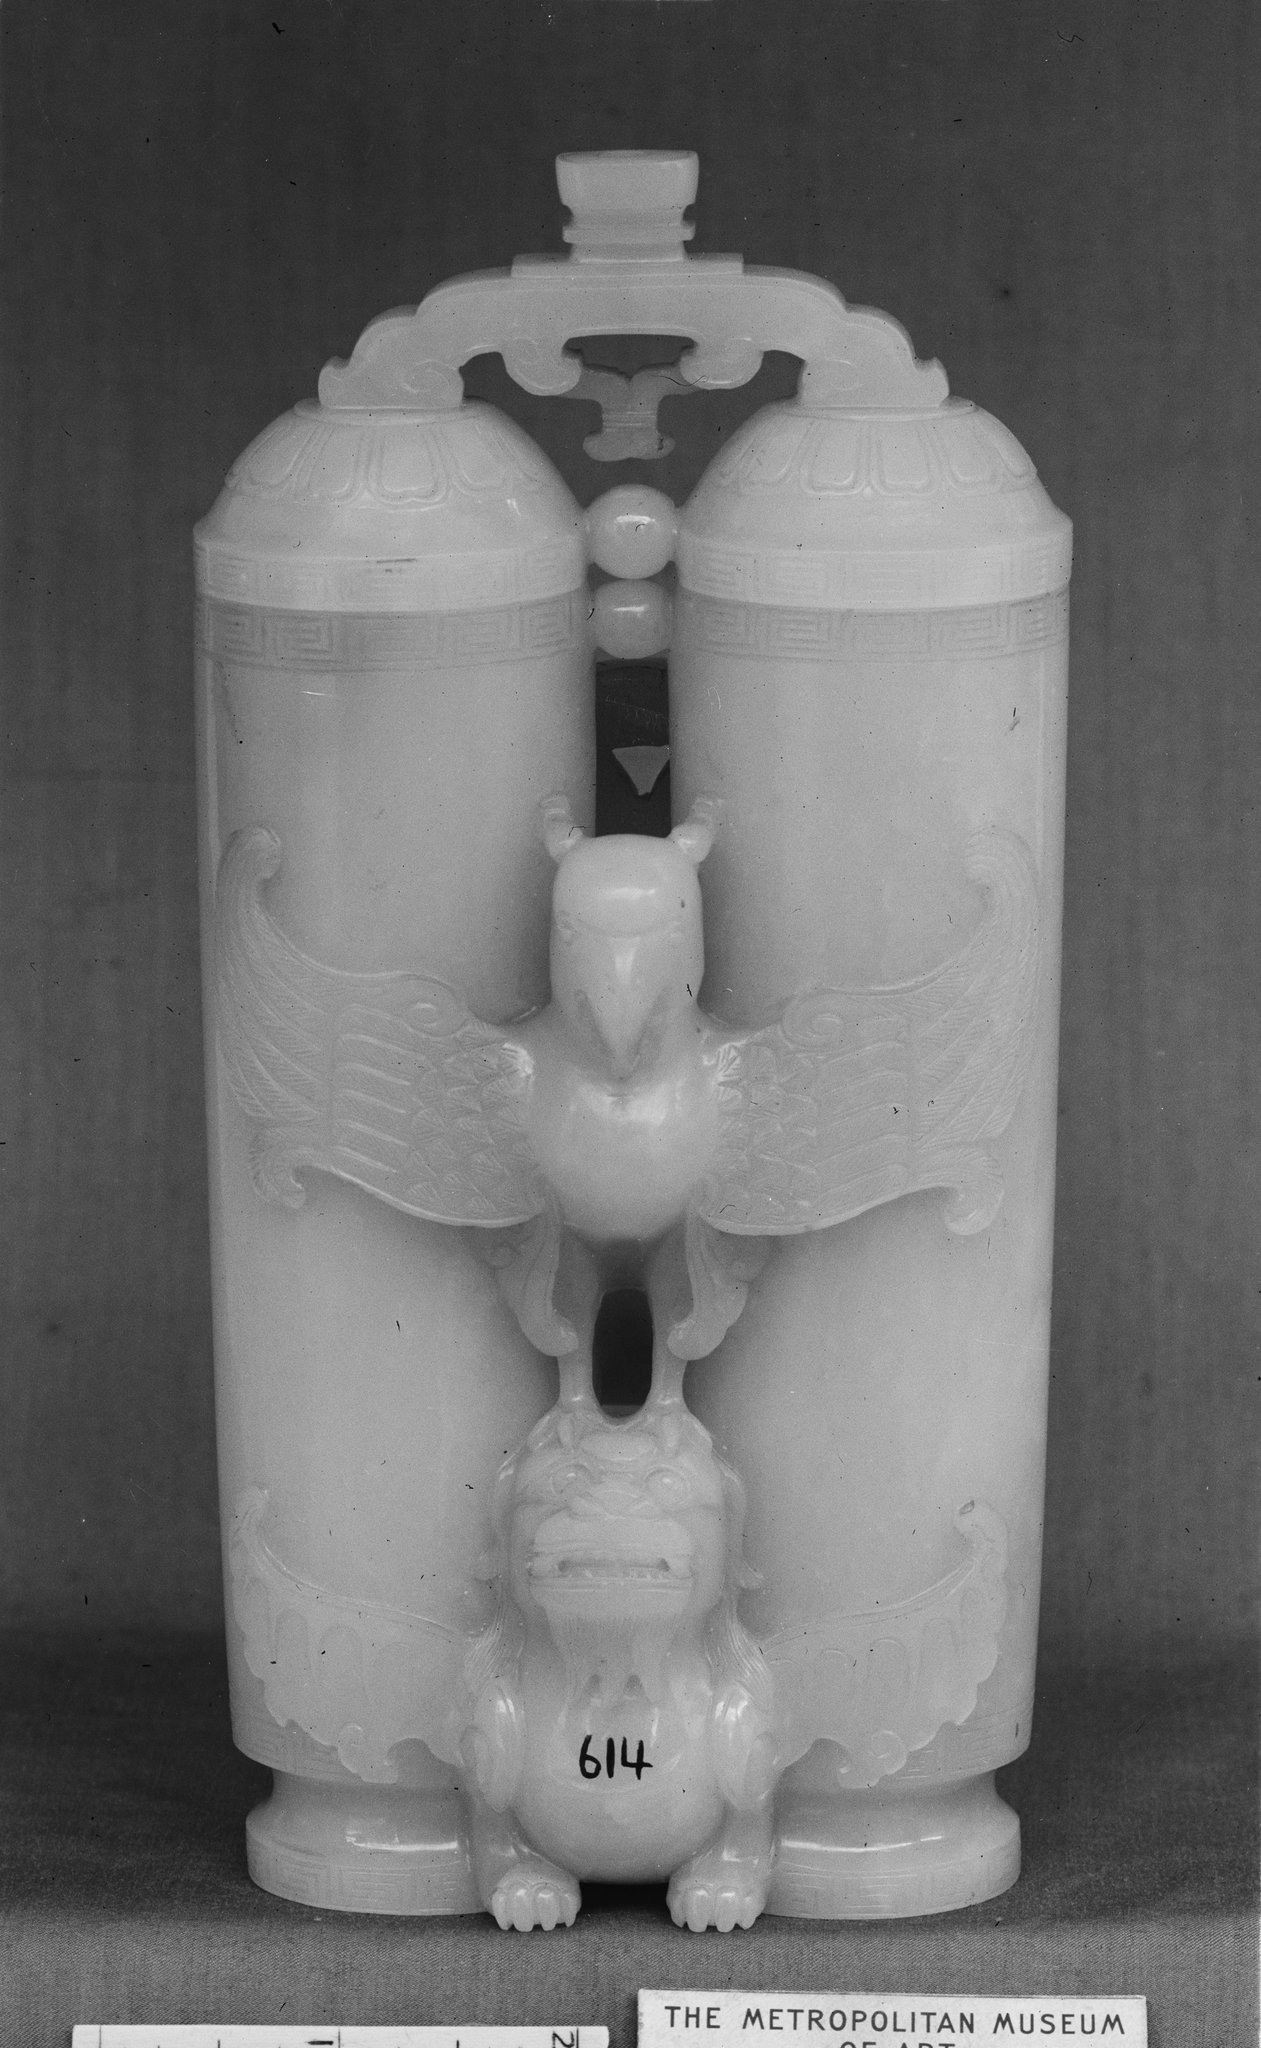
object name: champion vase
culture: chinese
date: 1701-1800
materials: jade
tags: mythical creatures